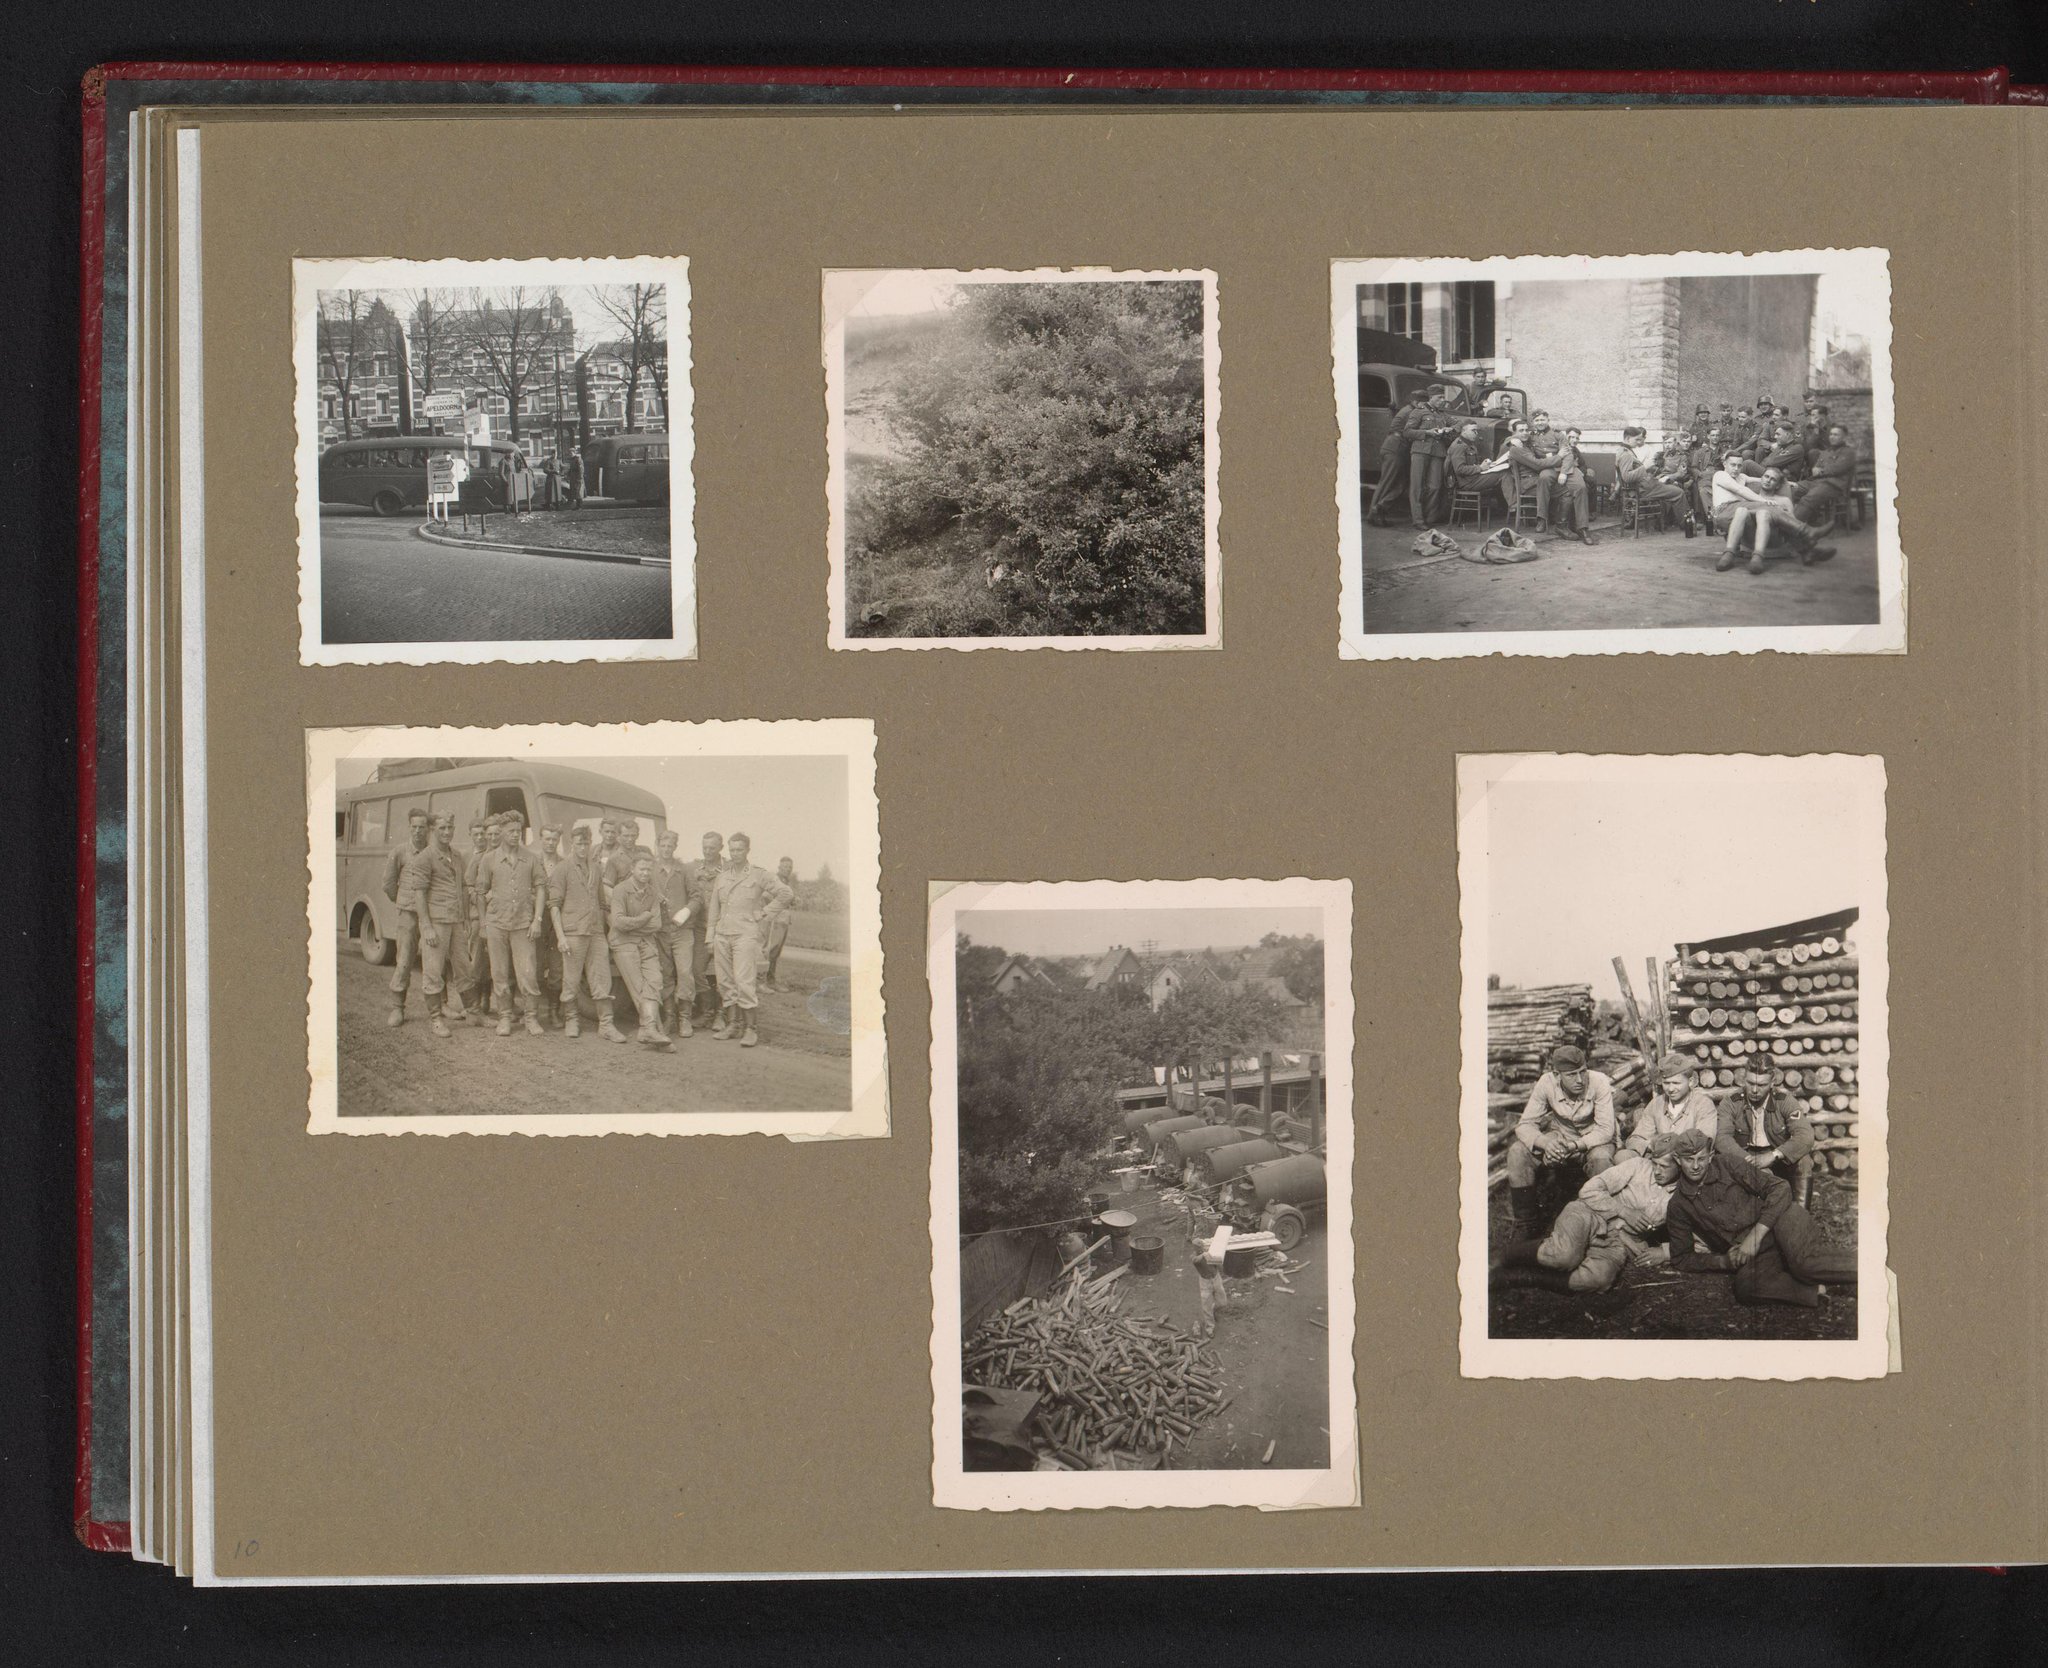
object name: photograph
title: Wehrmacht soldaten in Gelderland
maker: Anonymous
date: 1940-1943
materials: paper, photographic support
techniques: gelatin silver print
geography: gelderland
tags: the company, the unit, the troop ~ military service, the soldier; the soldier's life, occupation ~ war, gelderland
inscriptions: name: ‘Fotohuis Van Ter Beek’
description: Albumblad met zes foto's van de soldaten rustend en aan het werk in Nederland. Linksboven een foto van enkele militaire bussen bij een kruispunt in Arnhem met wegwijzers naar o.a. SS Hoofdkwartier, Willemsplein, Woeste Hoeve en Apeldoorn. Onderdeel van het fotoalbum over soldaten van de Wehrmacht, ca. 1939-1943.